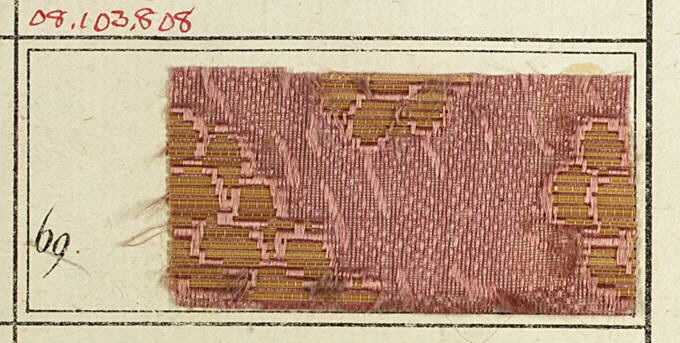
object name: ribbon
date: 1701-1900